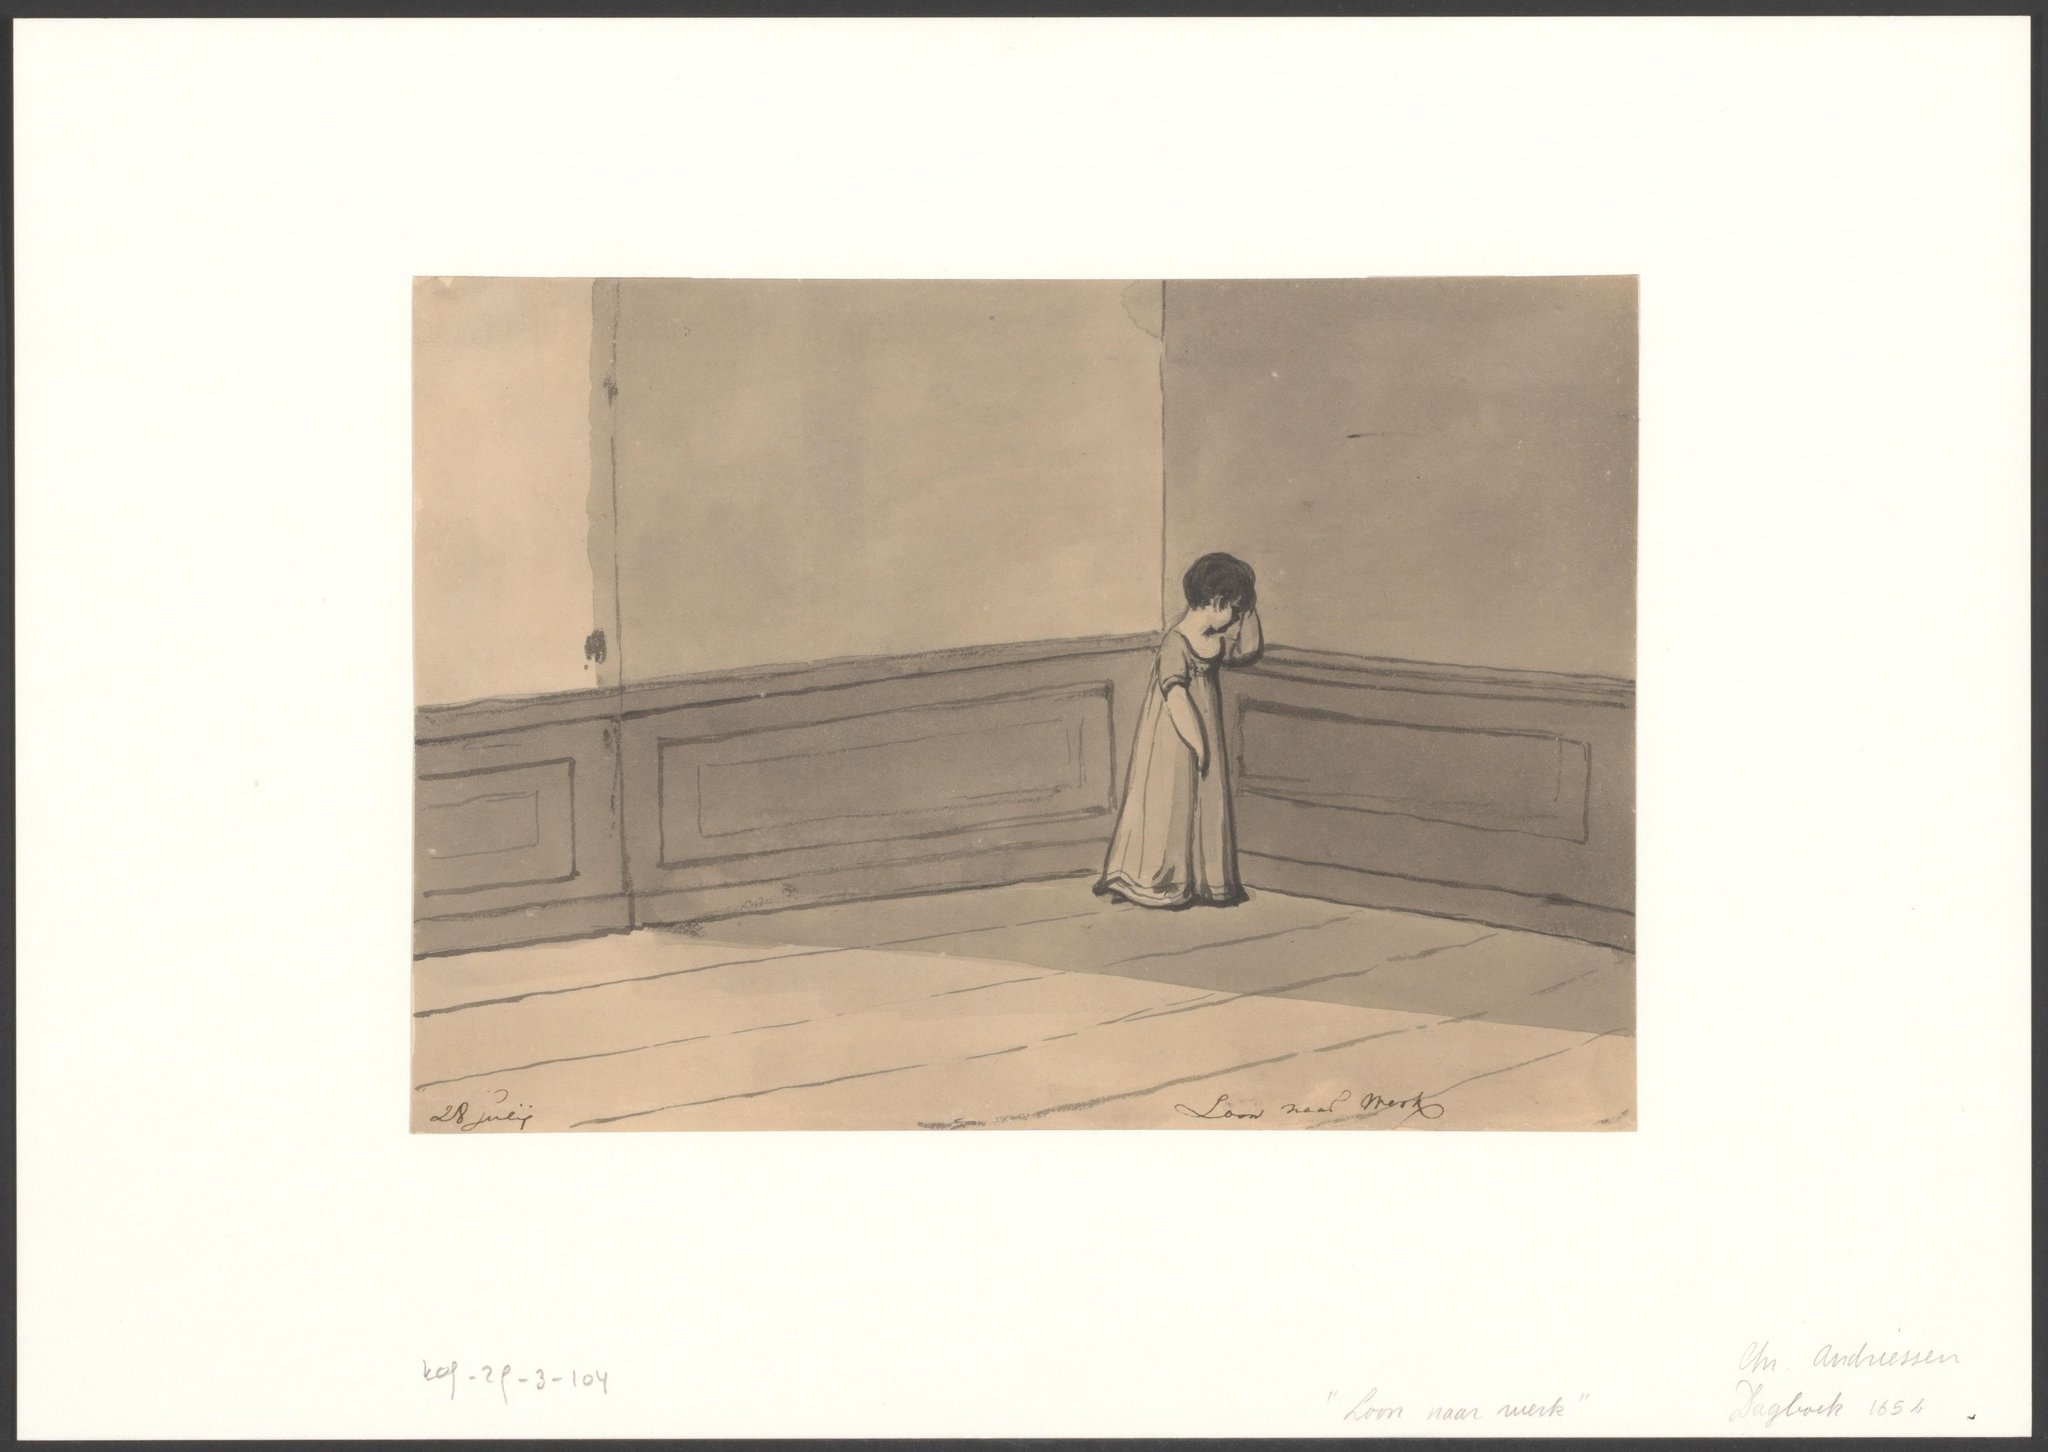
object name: drawing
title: Meisje met straf staat in de hoek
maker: christiaan andriessen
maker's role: draughtsman, print maker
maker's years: 1775-1846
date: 1806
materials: ink, paper, pencil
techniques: brush, pen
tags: correction of naughty children, the naughty child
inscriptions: signature: ‘J Andriessen’, inscription: ‘28 julij Loon naar werk’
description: Dagboekblad uit het getekende dagboek dat Christiaan Andriessen bijhield van 1805 tot en met 1808.